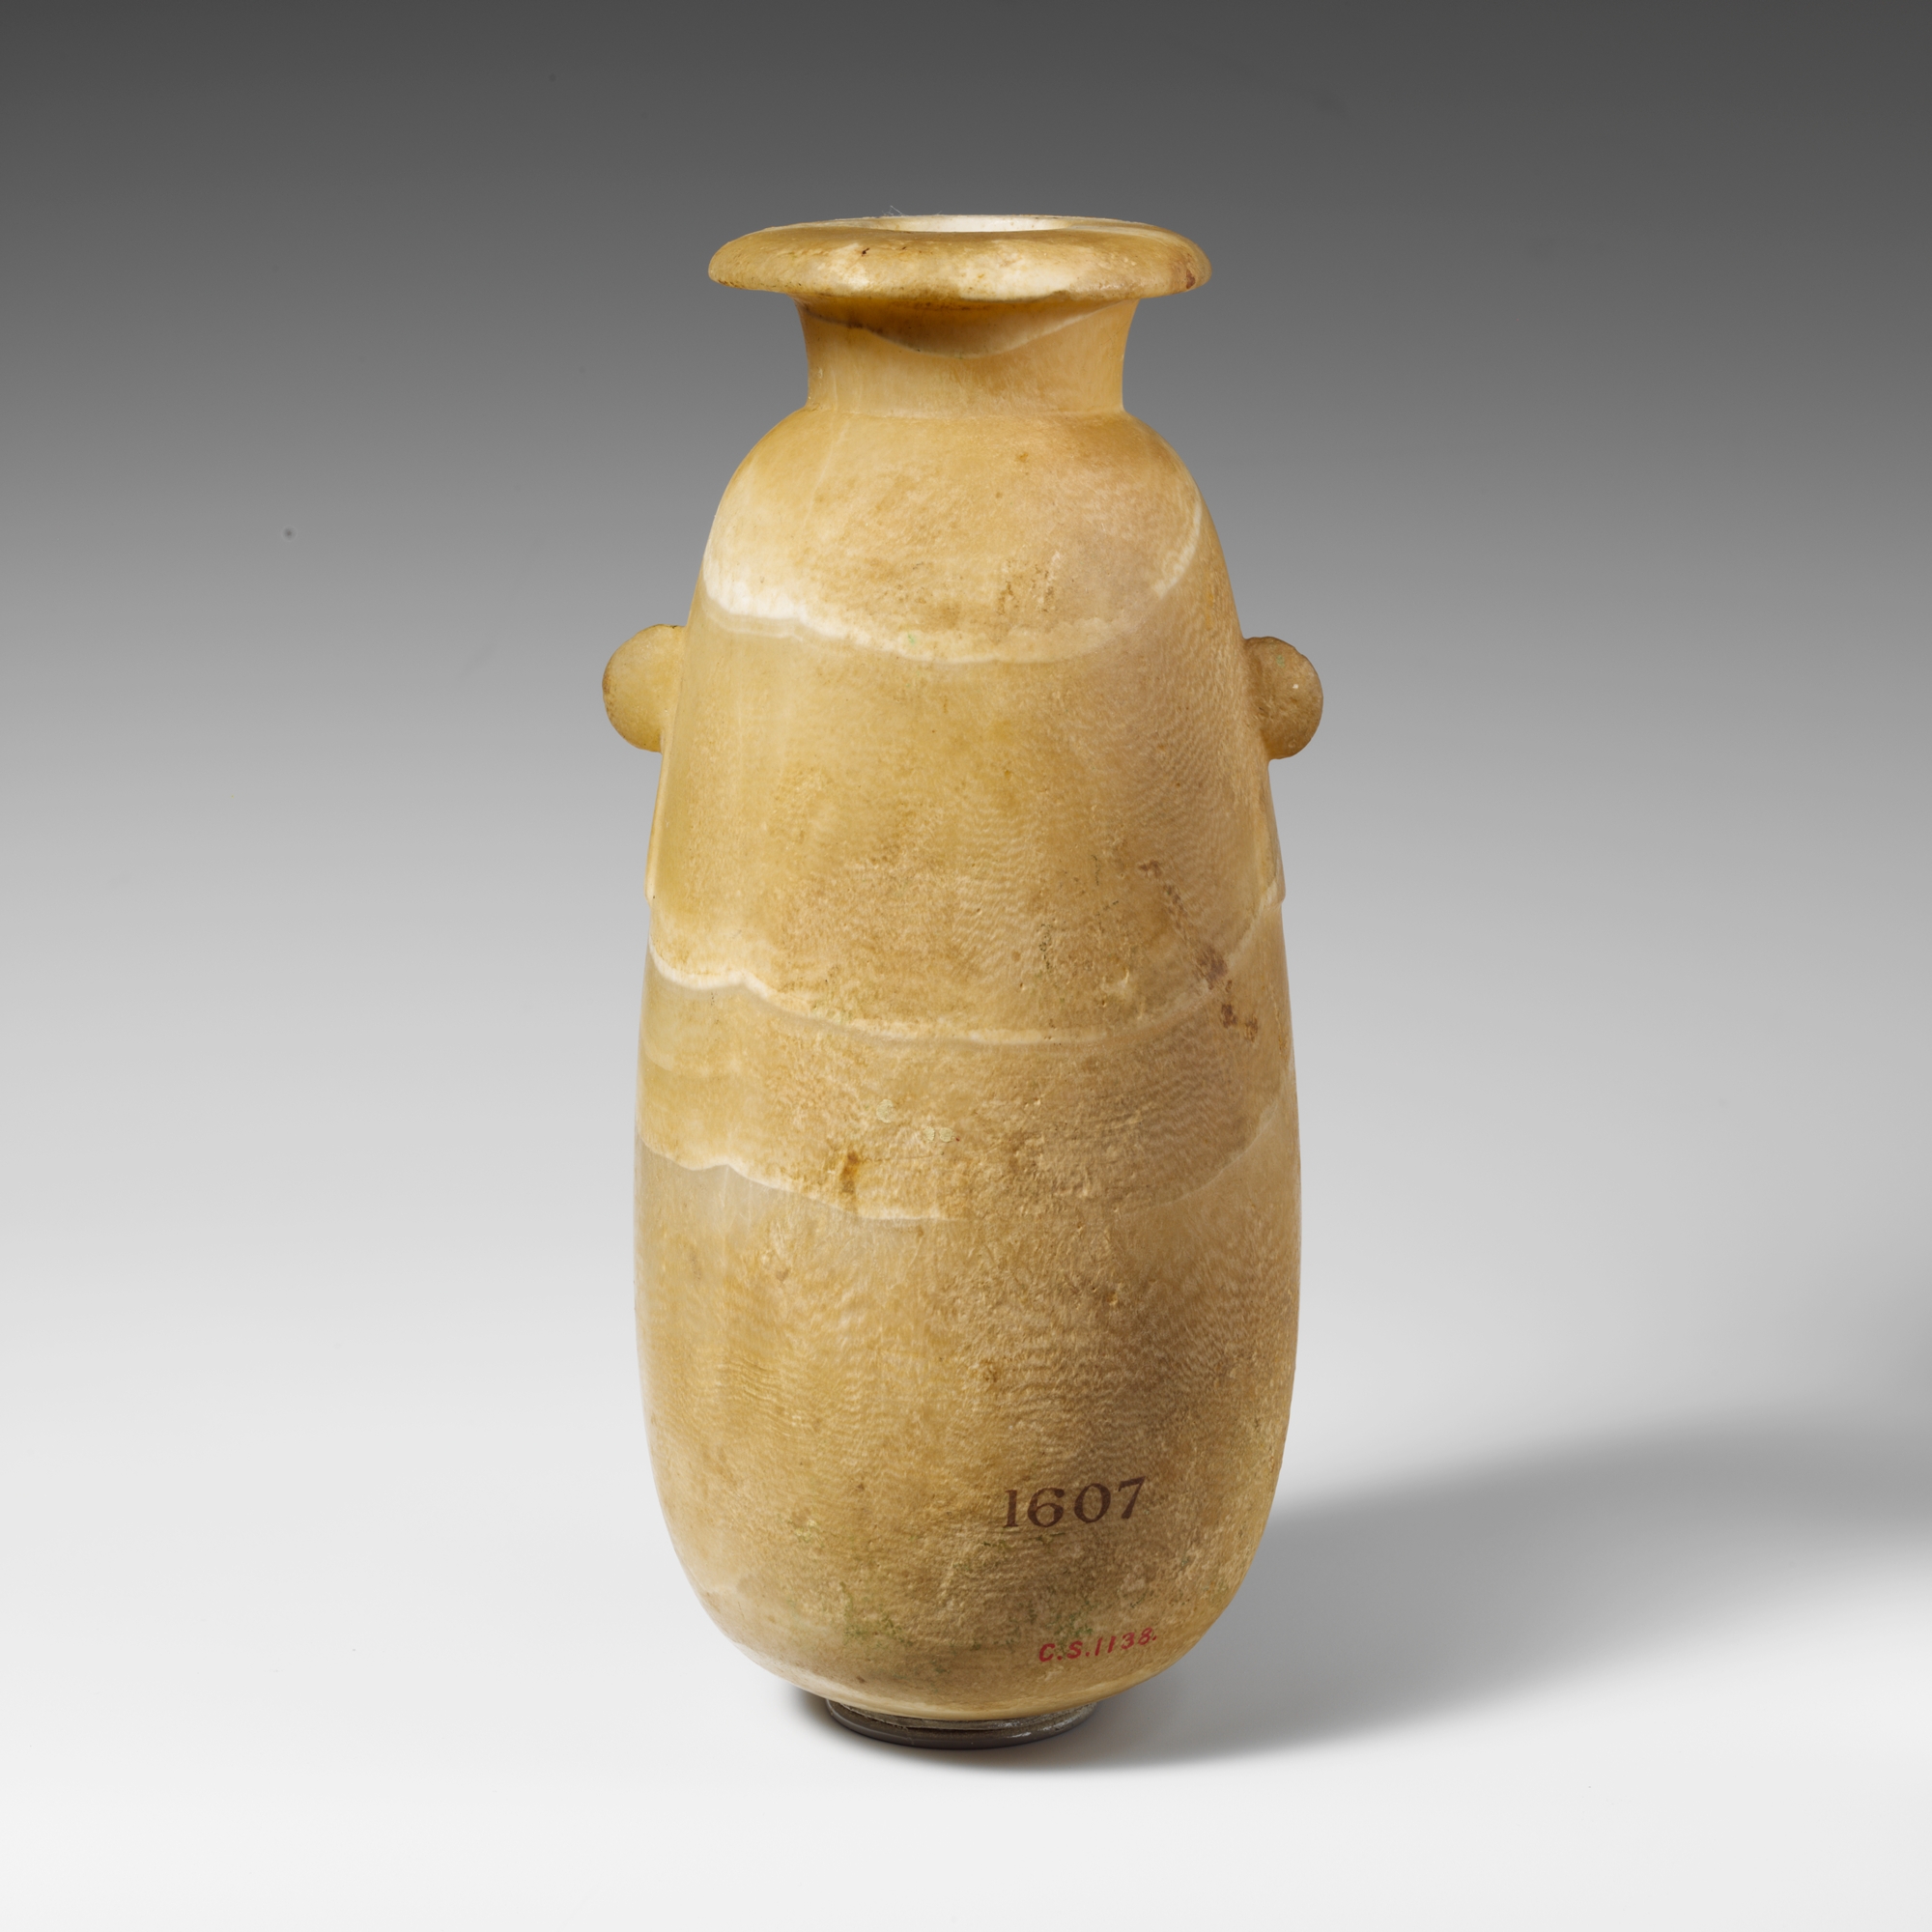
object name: alabastron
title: Alabaster alabastron (perfume vase)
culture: cypriot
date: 500-301 BCE